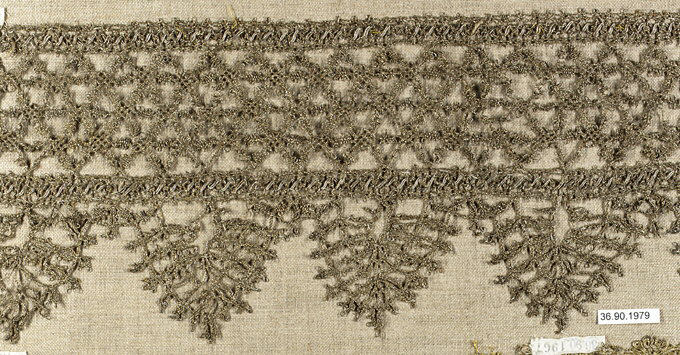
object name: piece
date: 1701-1800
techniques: lace